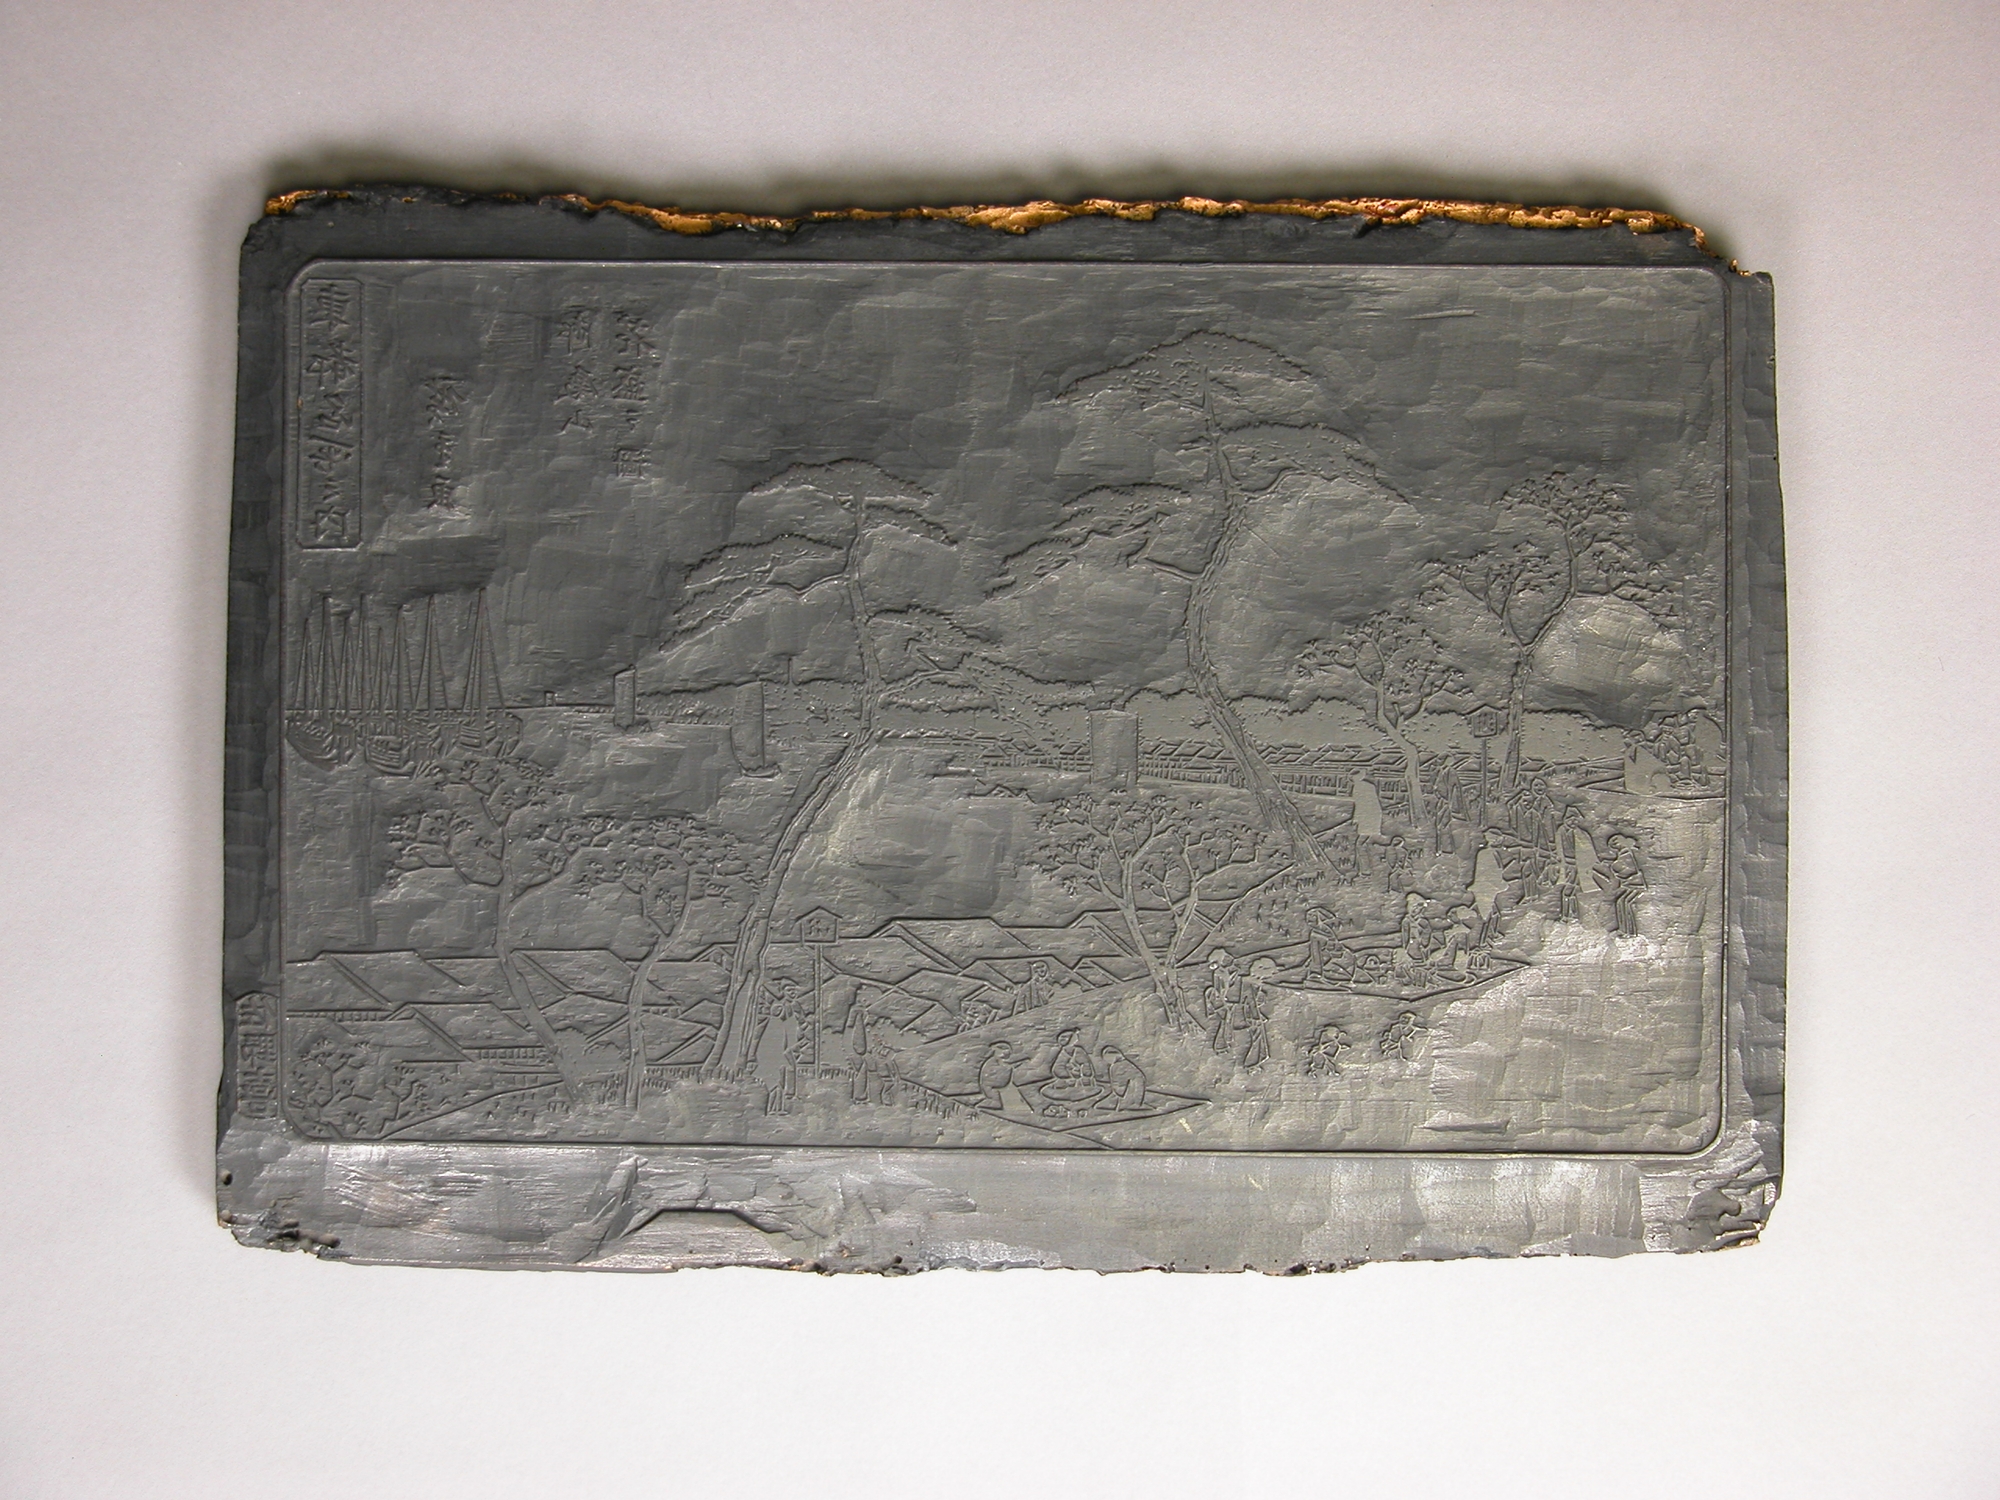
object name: printer's woodblock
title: Scene from Series of Scenes of Tokyo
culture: japanese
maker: utagawa hiroshige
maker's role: artist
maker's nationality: japanese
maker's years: 1797-1858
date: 1801-1900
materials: wood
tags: landscapes,trees